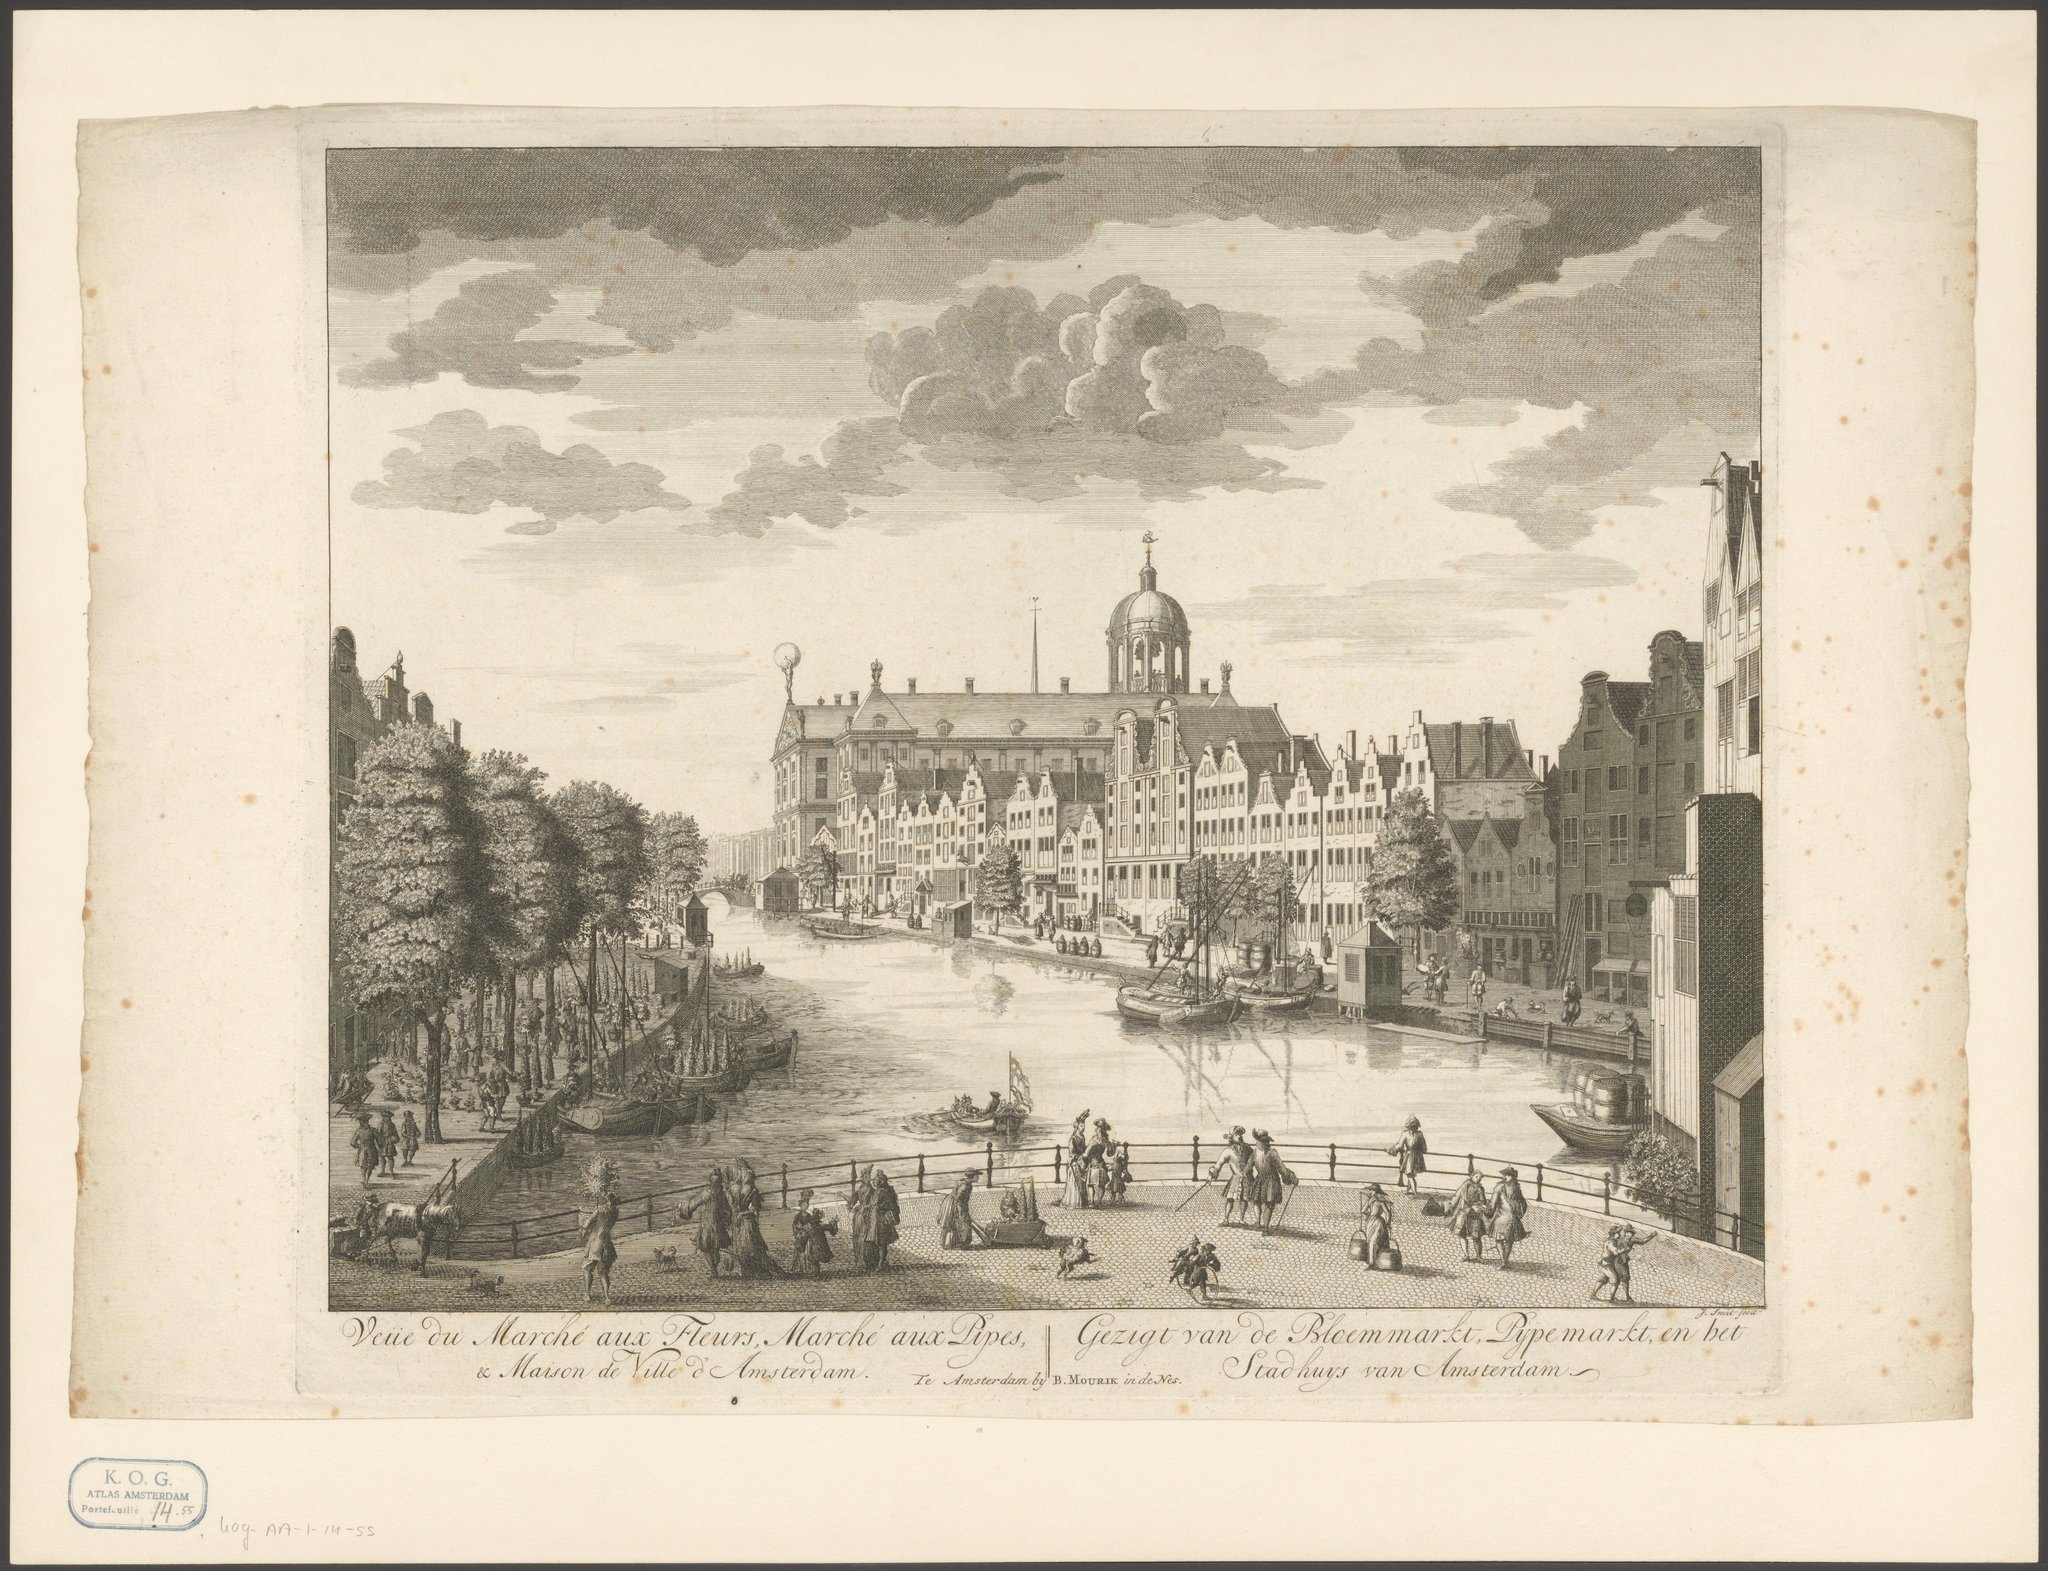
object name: print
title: Gezicht op de Nieuwezijds Voorburgwal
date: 1734-1768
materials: paper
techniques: engraving, etching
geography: amsterdam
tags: city-view in general; 'veduta', canal, townhall, the usual house or row of houses, bridge in city across river, canal, etc., street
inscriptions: collector's mark: ‘14.55’ Lugt 1641b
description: Onderwerpsrubriek binnen de Atlas Amsterdam: Verhulststraat (Johannes), Viaducten, Vierwindenstraat, Vinkenbuurt, Vinkenpad, Vinkenstraat, Vischsteeg, Vliegendesteeg, Voetboogstraat, Volewijk, Vondelstraat, Voorburgwal (N.Z.).